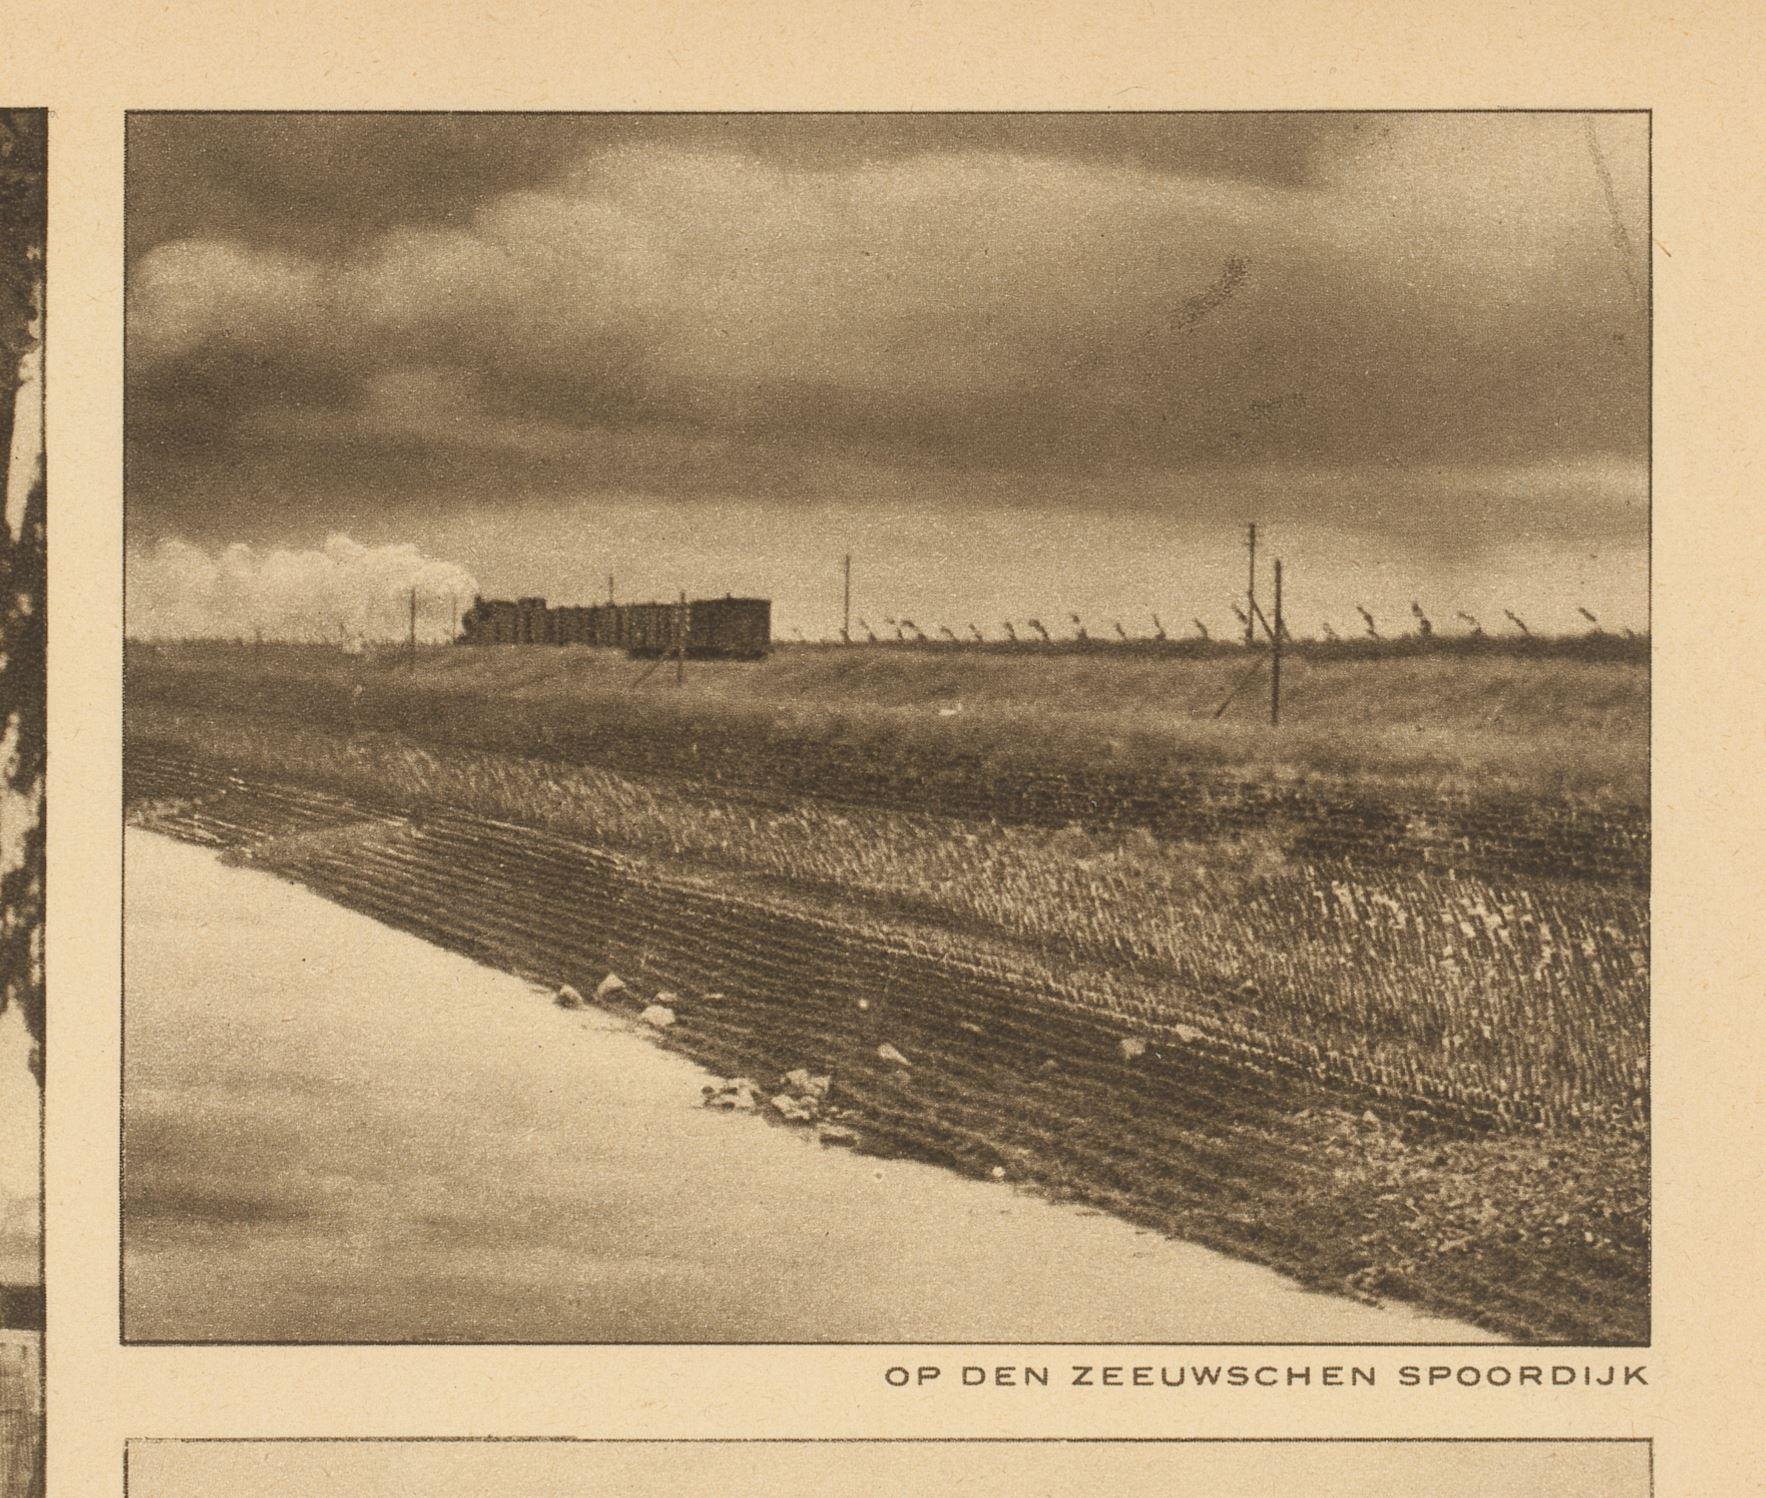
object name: photomechanical print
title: Gezicht op een trein op het spoor in Zeeland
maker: Anonymous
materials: paper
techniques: rotogravure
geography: leiden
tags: railway, train, zeeland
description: Deze prent maakt deel uit van een album.